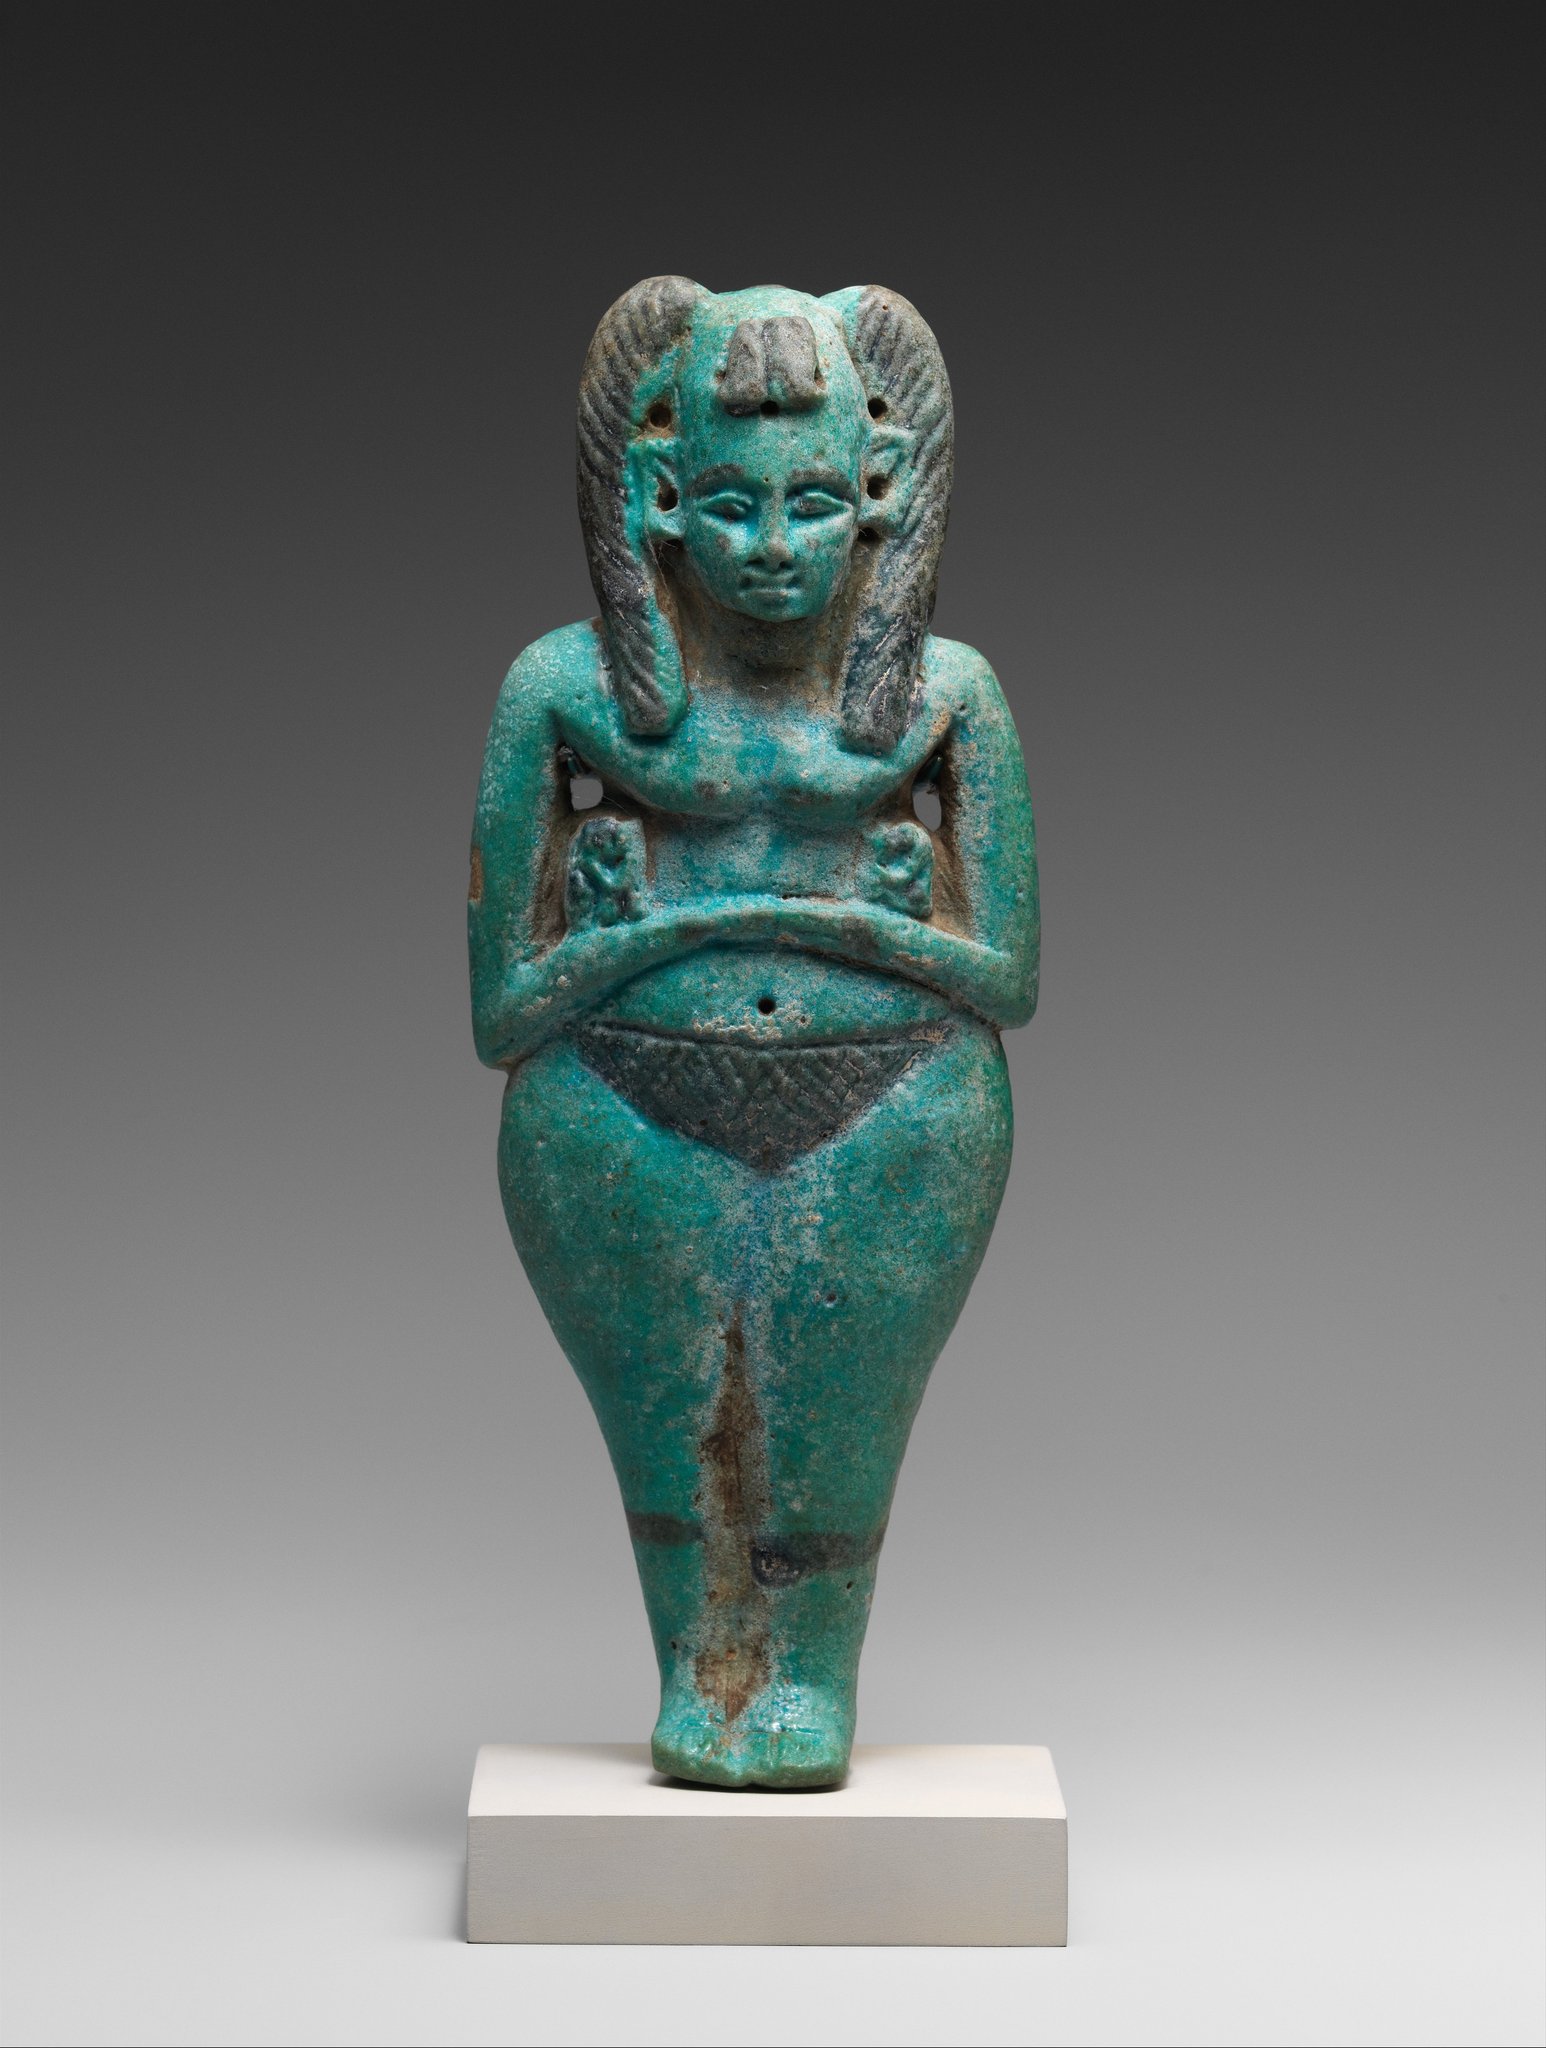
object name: statuette, nude woman, monkey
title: Nude female holding monkeys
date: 1070-664 BCE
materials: faience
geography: egypt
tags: female nudes,monkeys